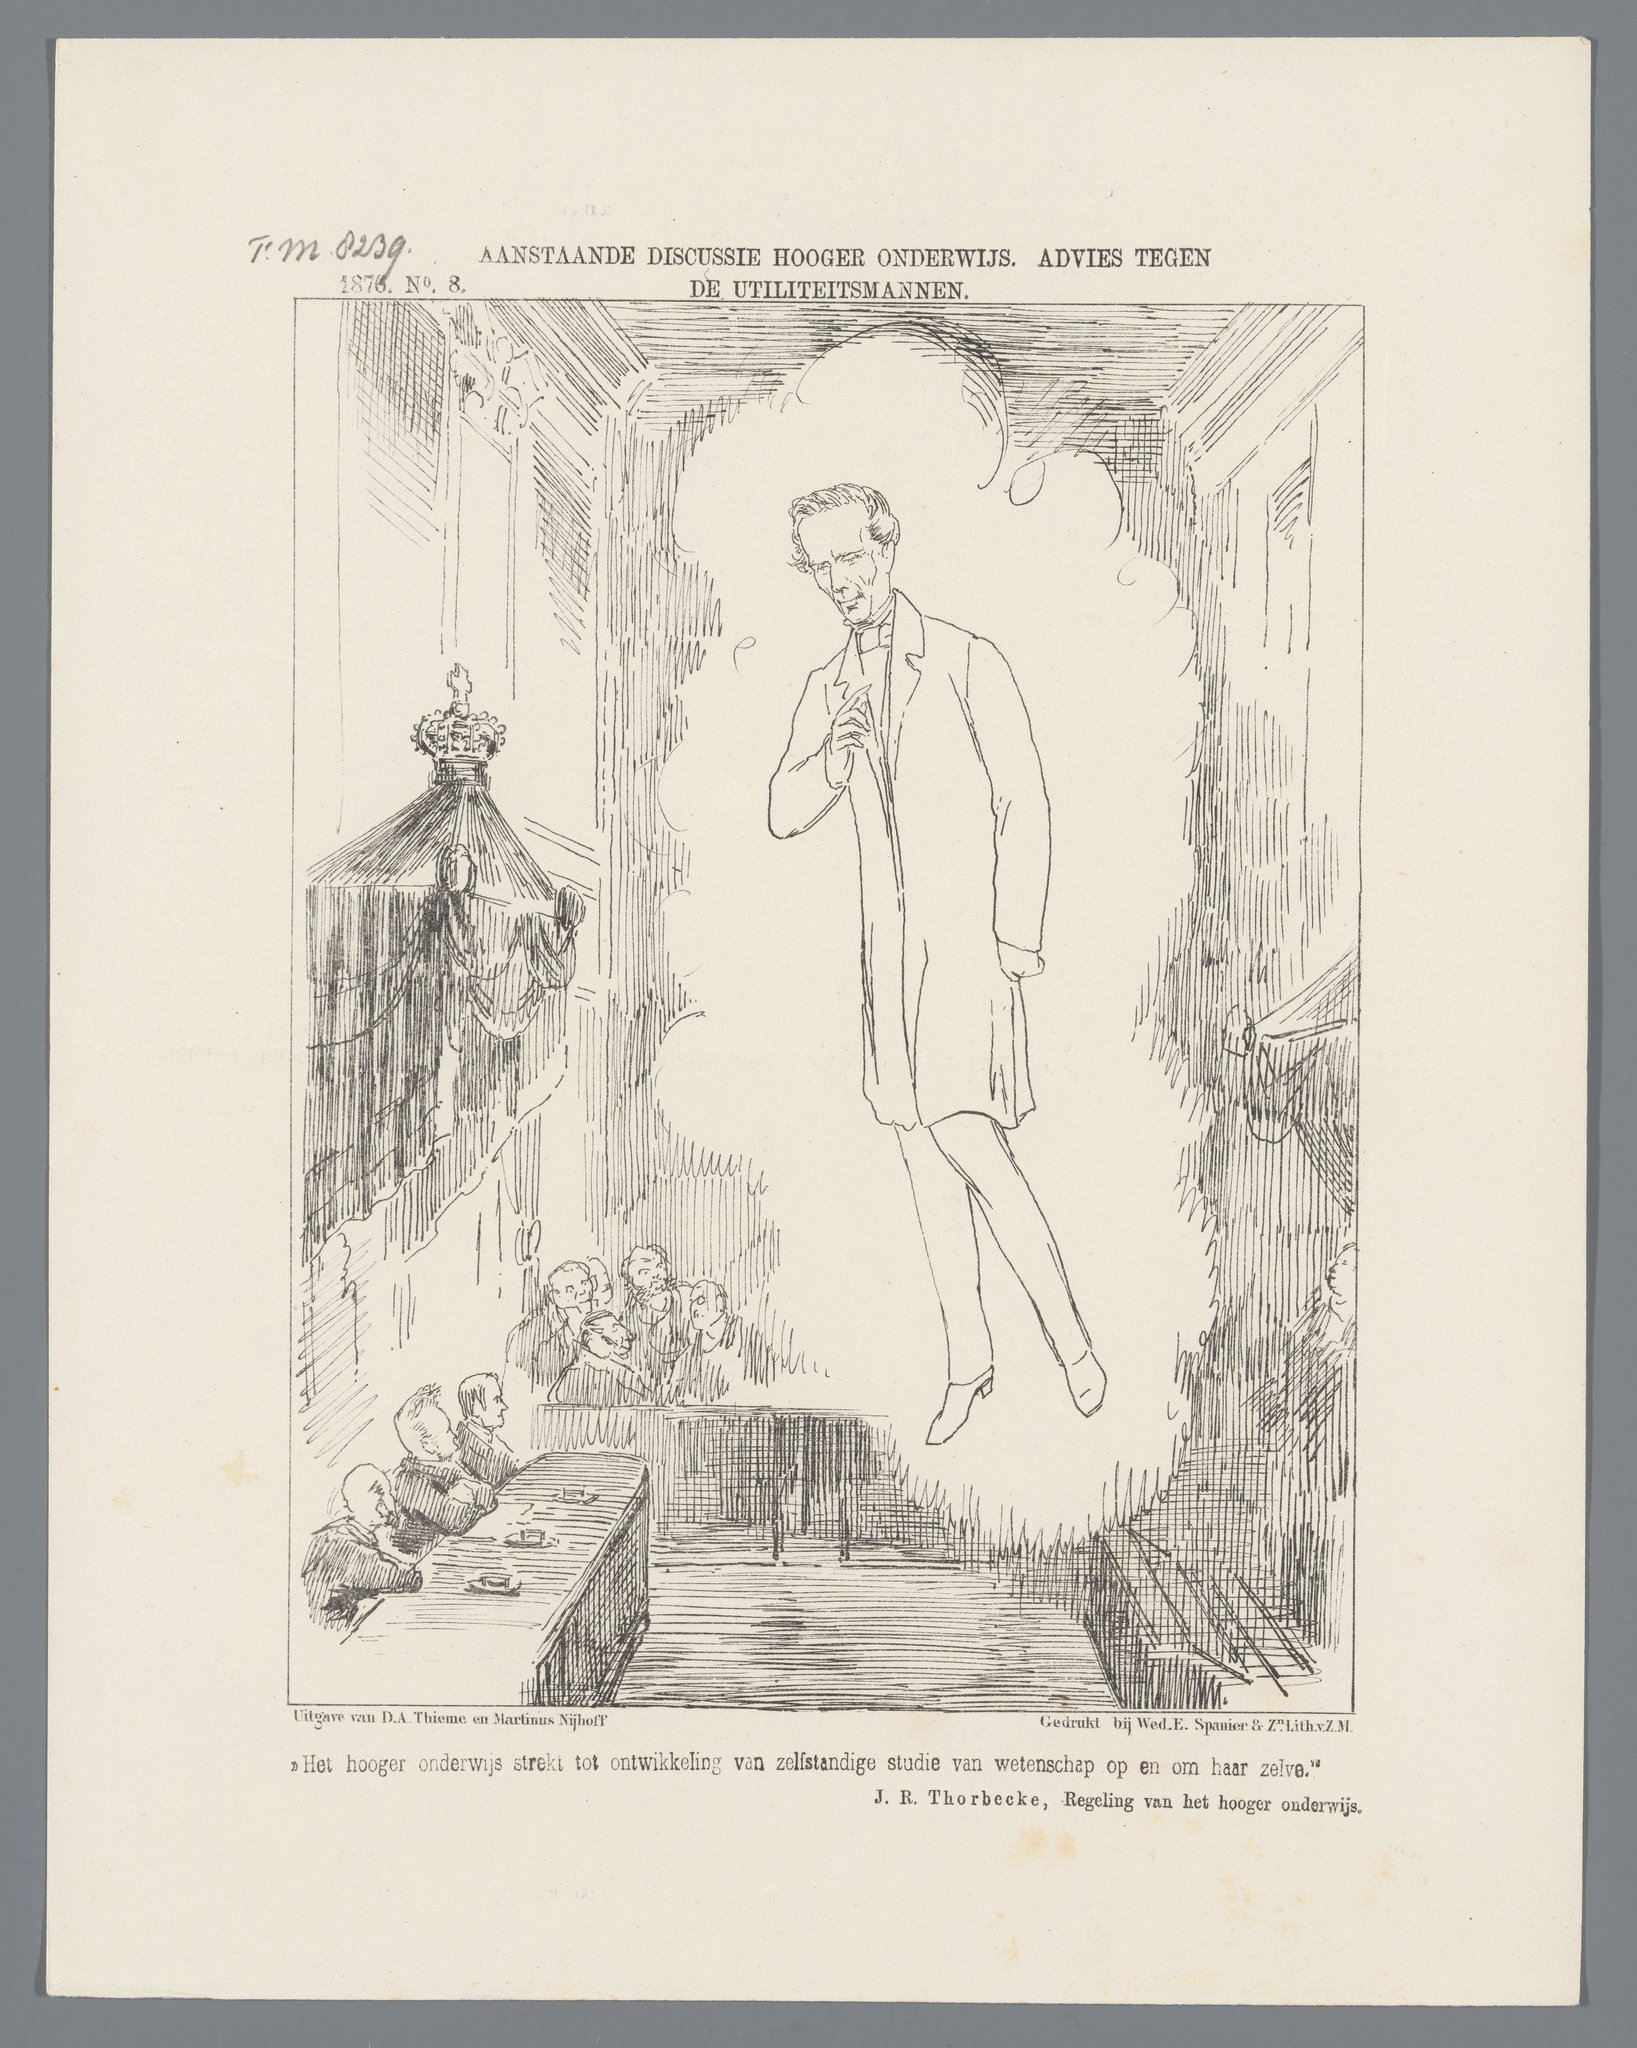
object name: print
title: Zaanlandsche Zeil & Roeivereeniging. 24 Julij 1852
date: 1852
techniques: printmaking, lithograph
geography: netherlands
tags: sailing (sport)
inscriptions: collector's mark: Lugt 2228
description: Zeilwedstrijd op de Zaan, met de finish van de winnaar bij de publieke tribune opgebouwd voor het stadhuis. Wedstrijd georganiseerd door de Zaanlandsche Zeil & Roeivereeniging, 24 juli 1852. In een omlijsting met gezichten te en belangrijke gebouwen van Zaandam. Bij de prent behoort een programma van de wedstrijd.